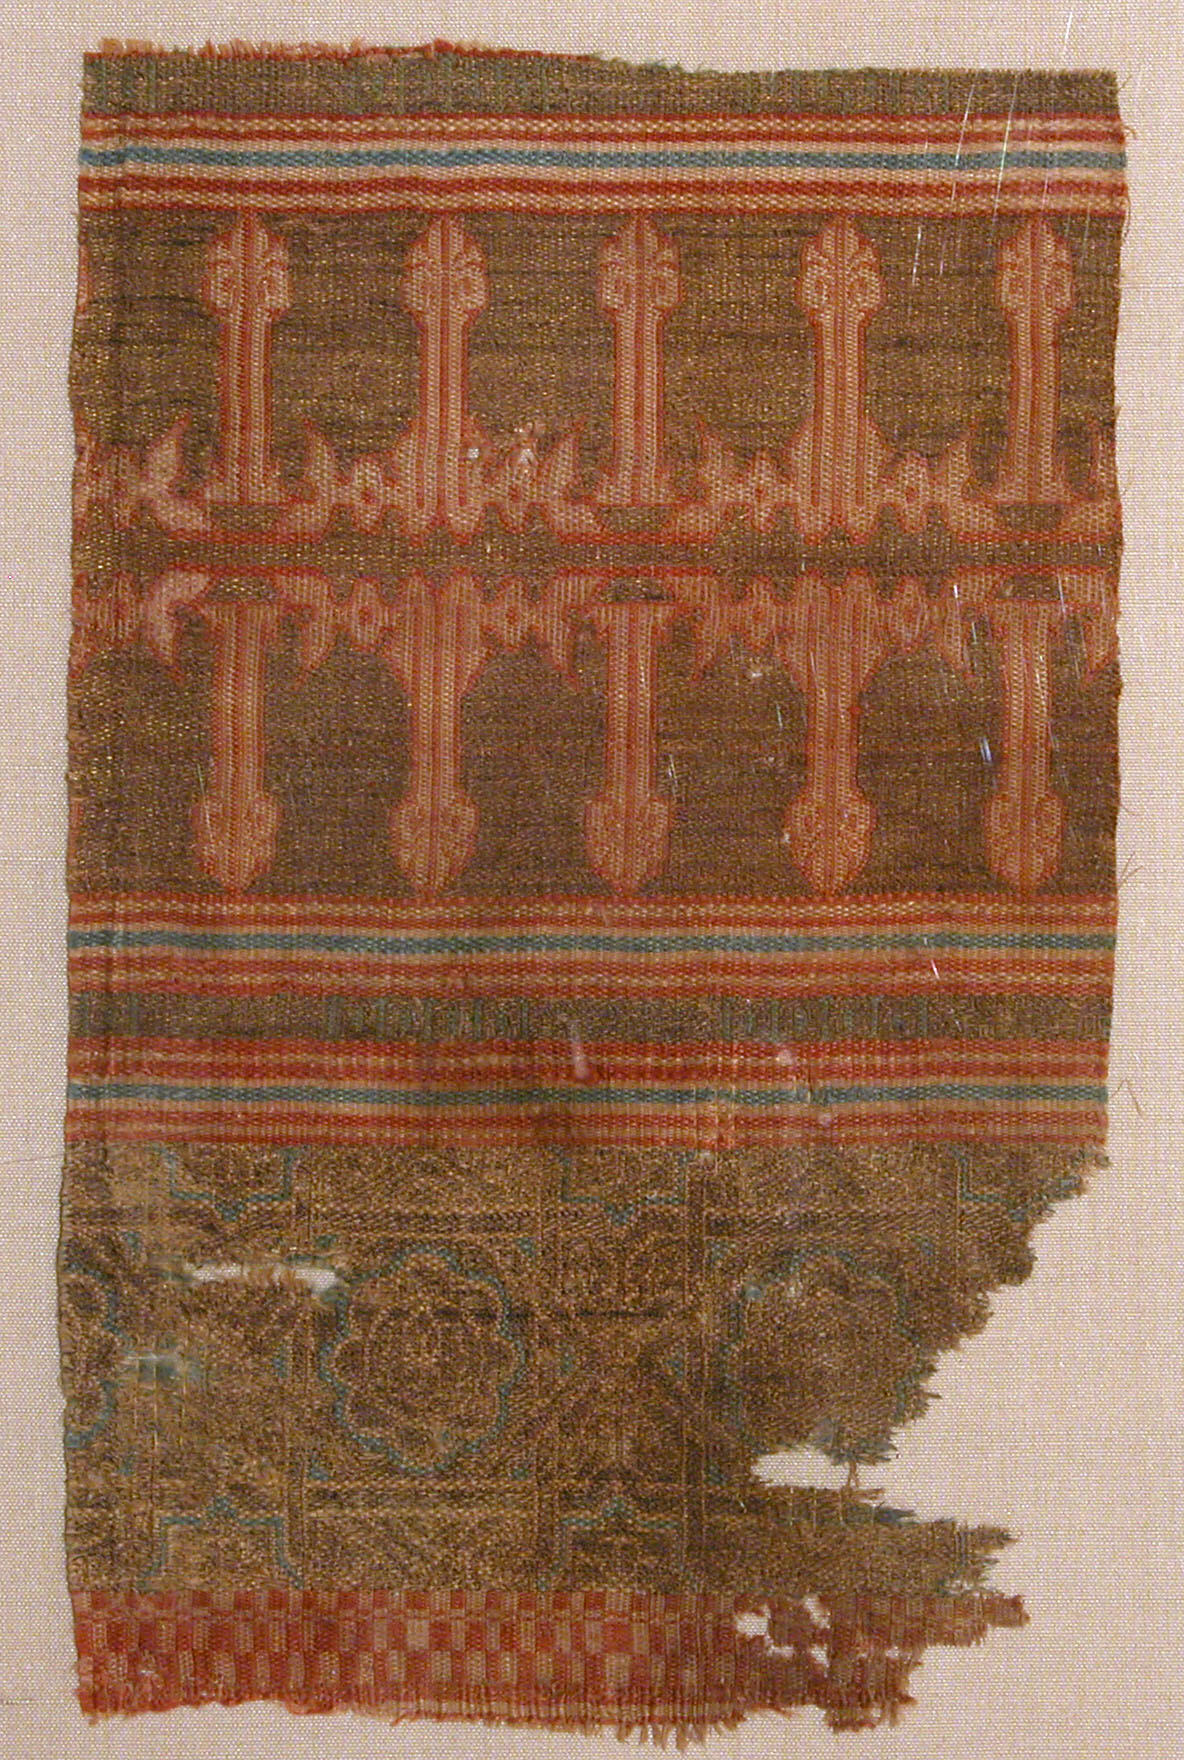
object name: textile fragment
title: Textile Fragment from the Tomb of Don Felipe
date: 1251-1300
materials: linen, metal thread, silk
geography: spain